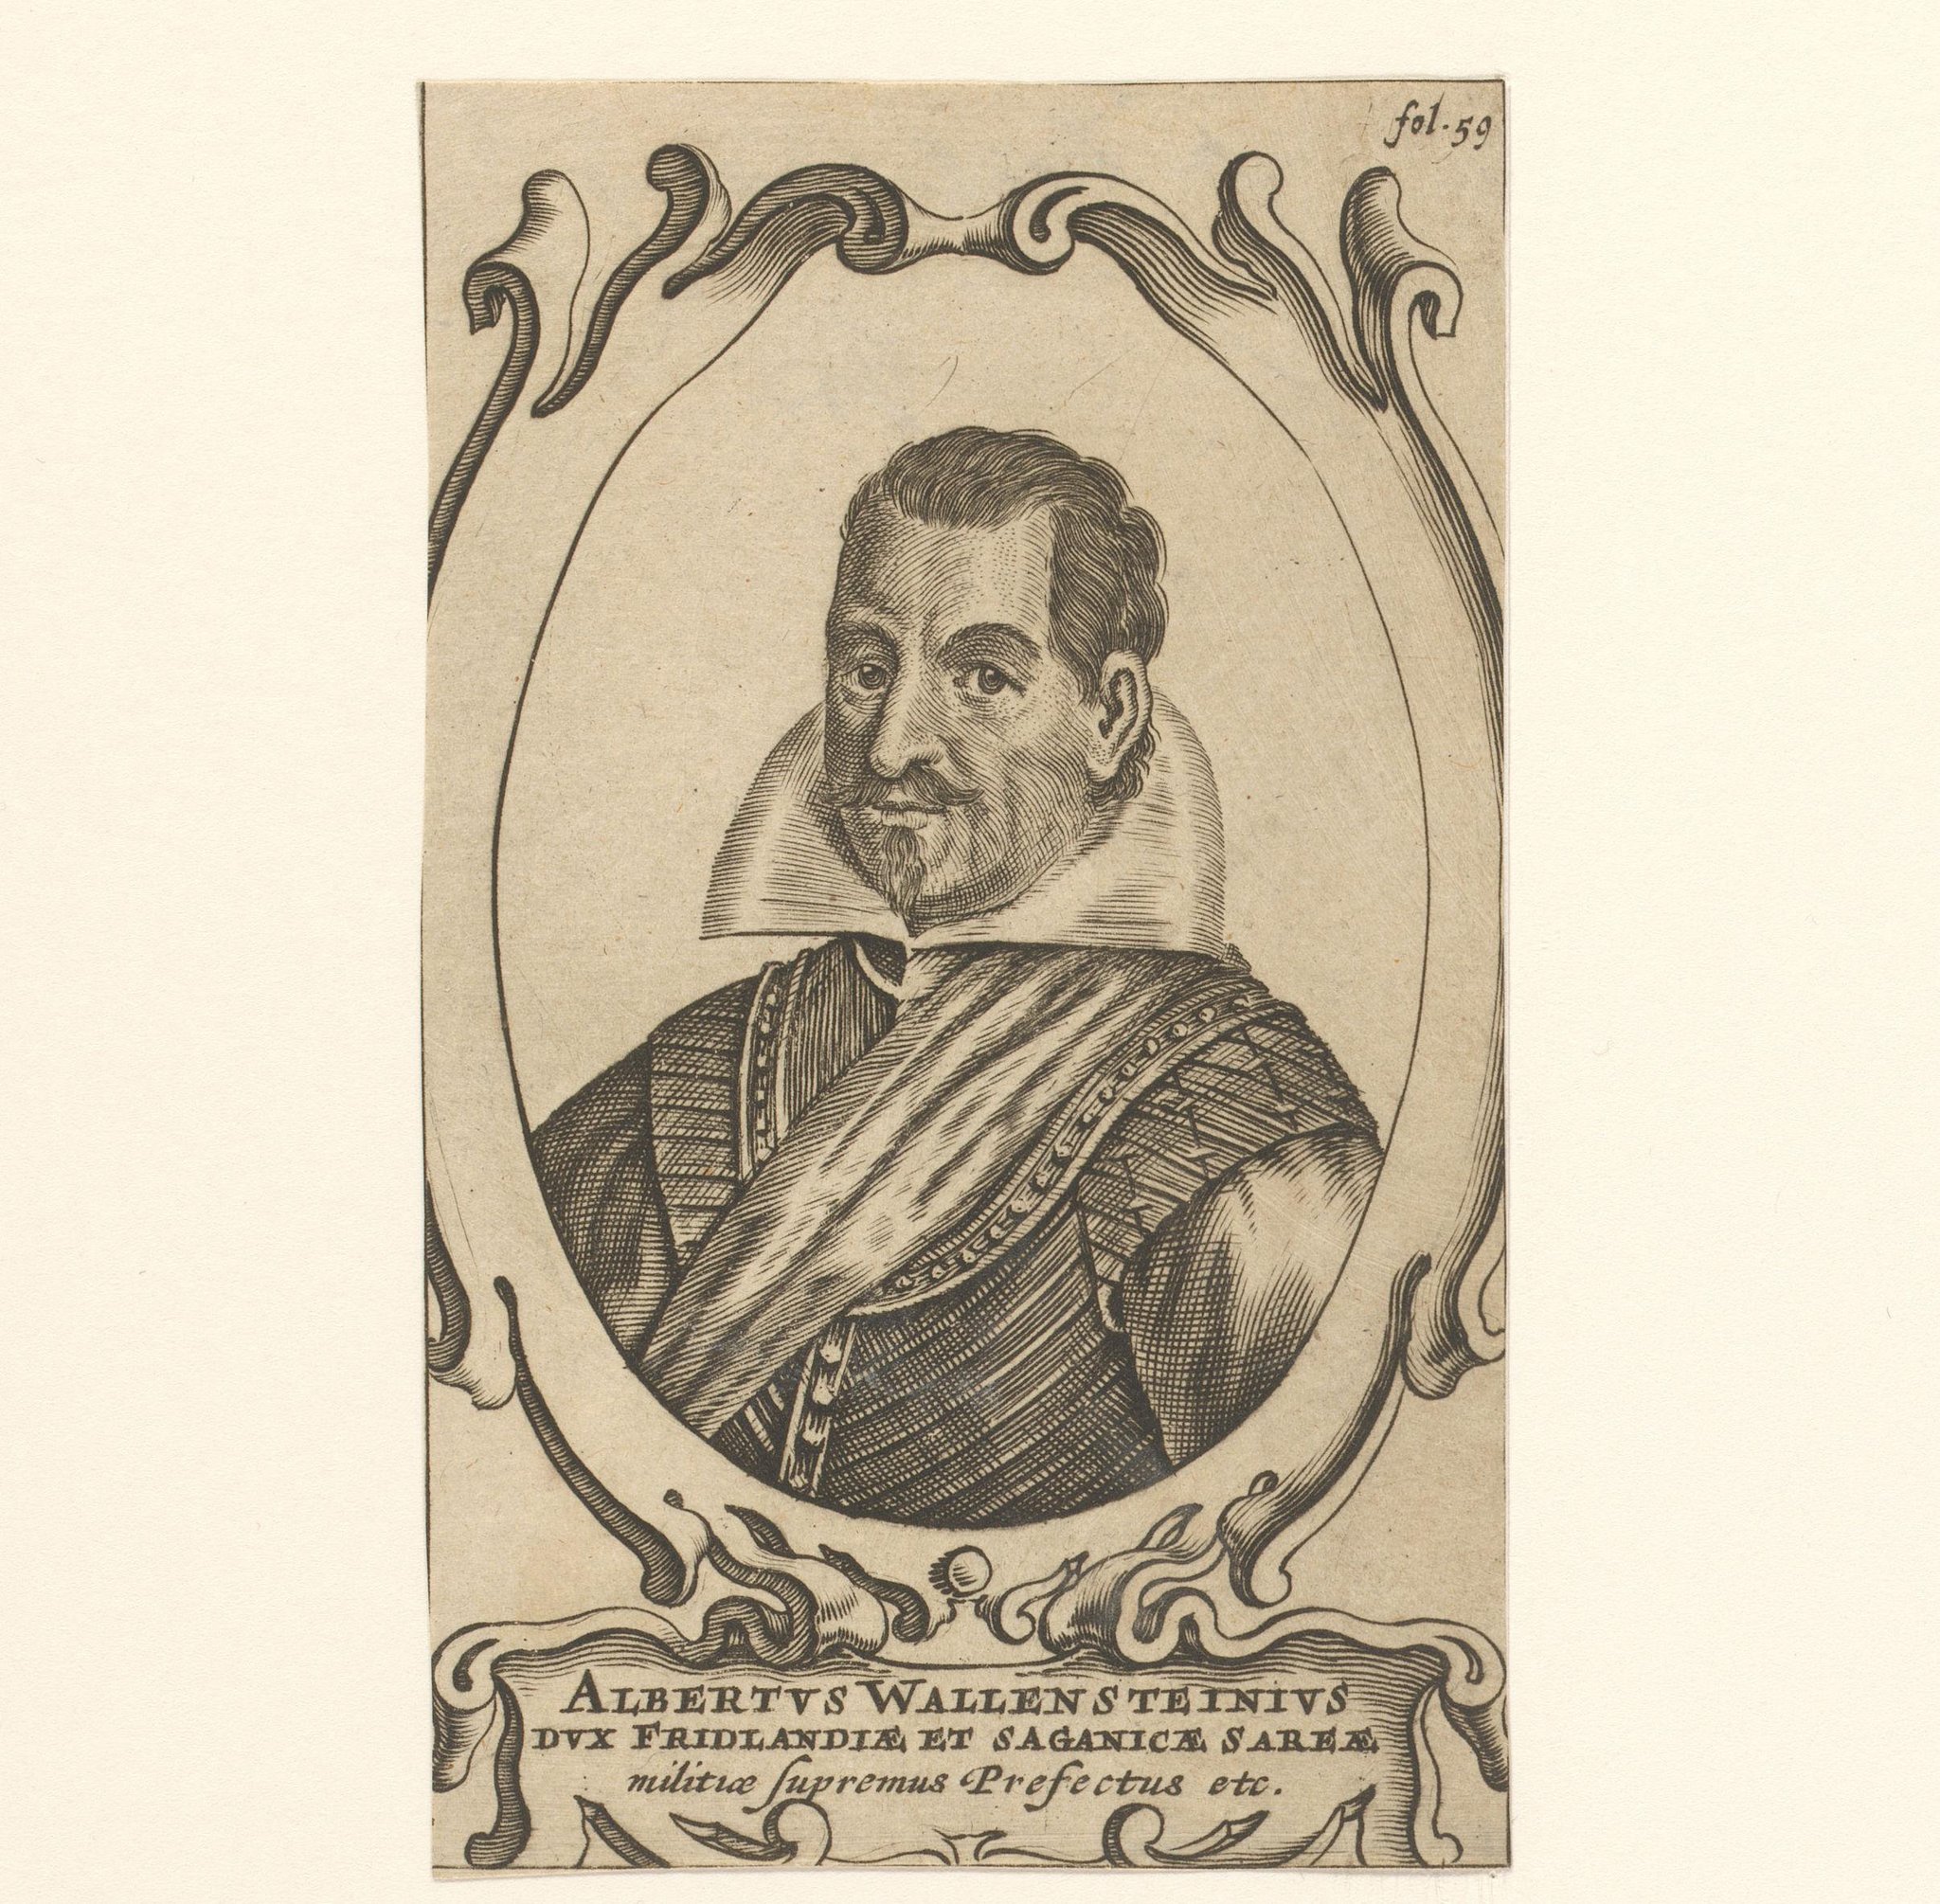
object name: print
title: Albertus Wallensteinius dux Fridlandiae et Saganicae Sareae (...)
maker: Anonymous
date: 1656-1666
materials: paper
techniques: engraving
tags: commander-in-chief, general, marshal, historical persons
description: Prent gebruikt in: Brachelius, Johannes Adolphus. Historia nostri temporis, dat is: geschiedenis onses tijdts, (...). Rotterdam: Andries van Hoogenhuyse, 1656. Prent in ieder geval ook gebruikt in hetzelfde boek uitgegeven door Andries van Hoogenhuyse in Nijmegen in 1659 en uitgegeven door Samuel Imbrecht in Amsterdam in 1666.